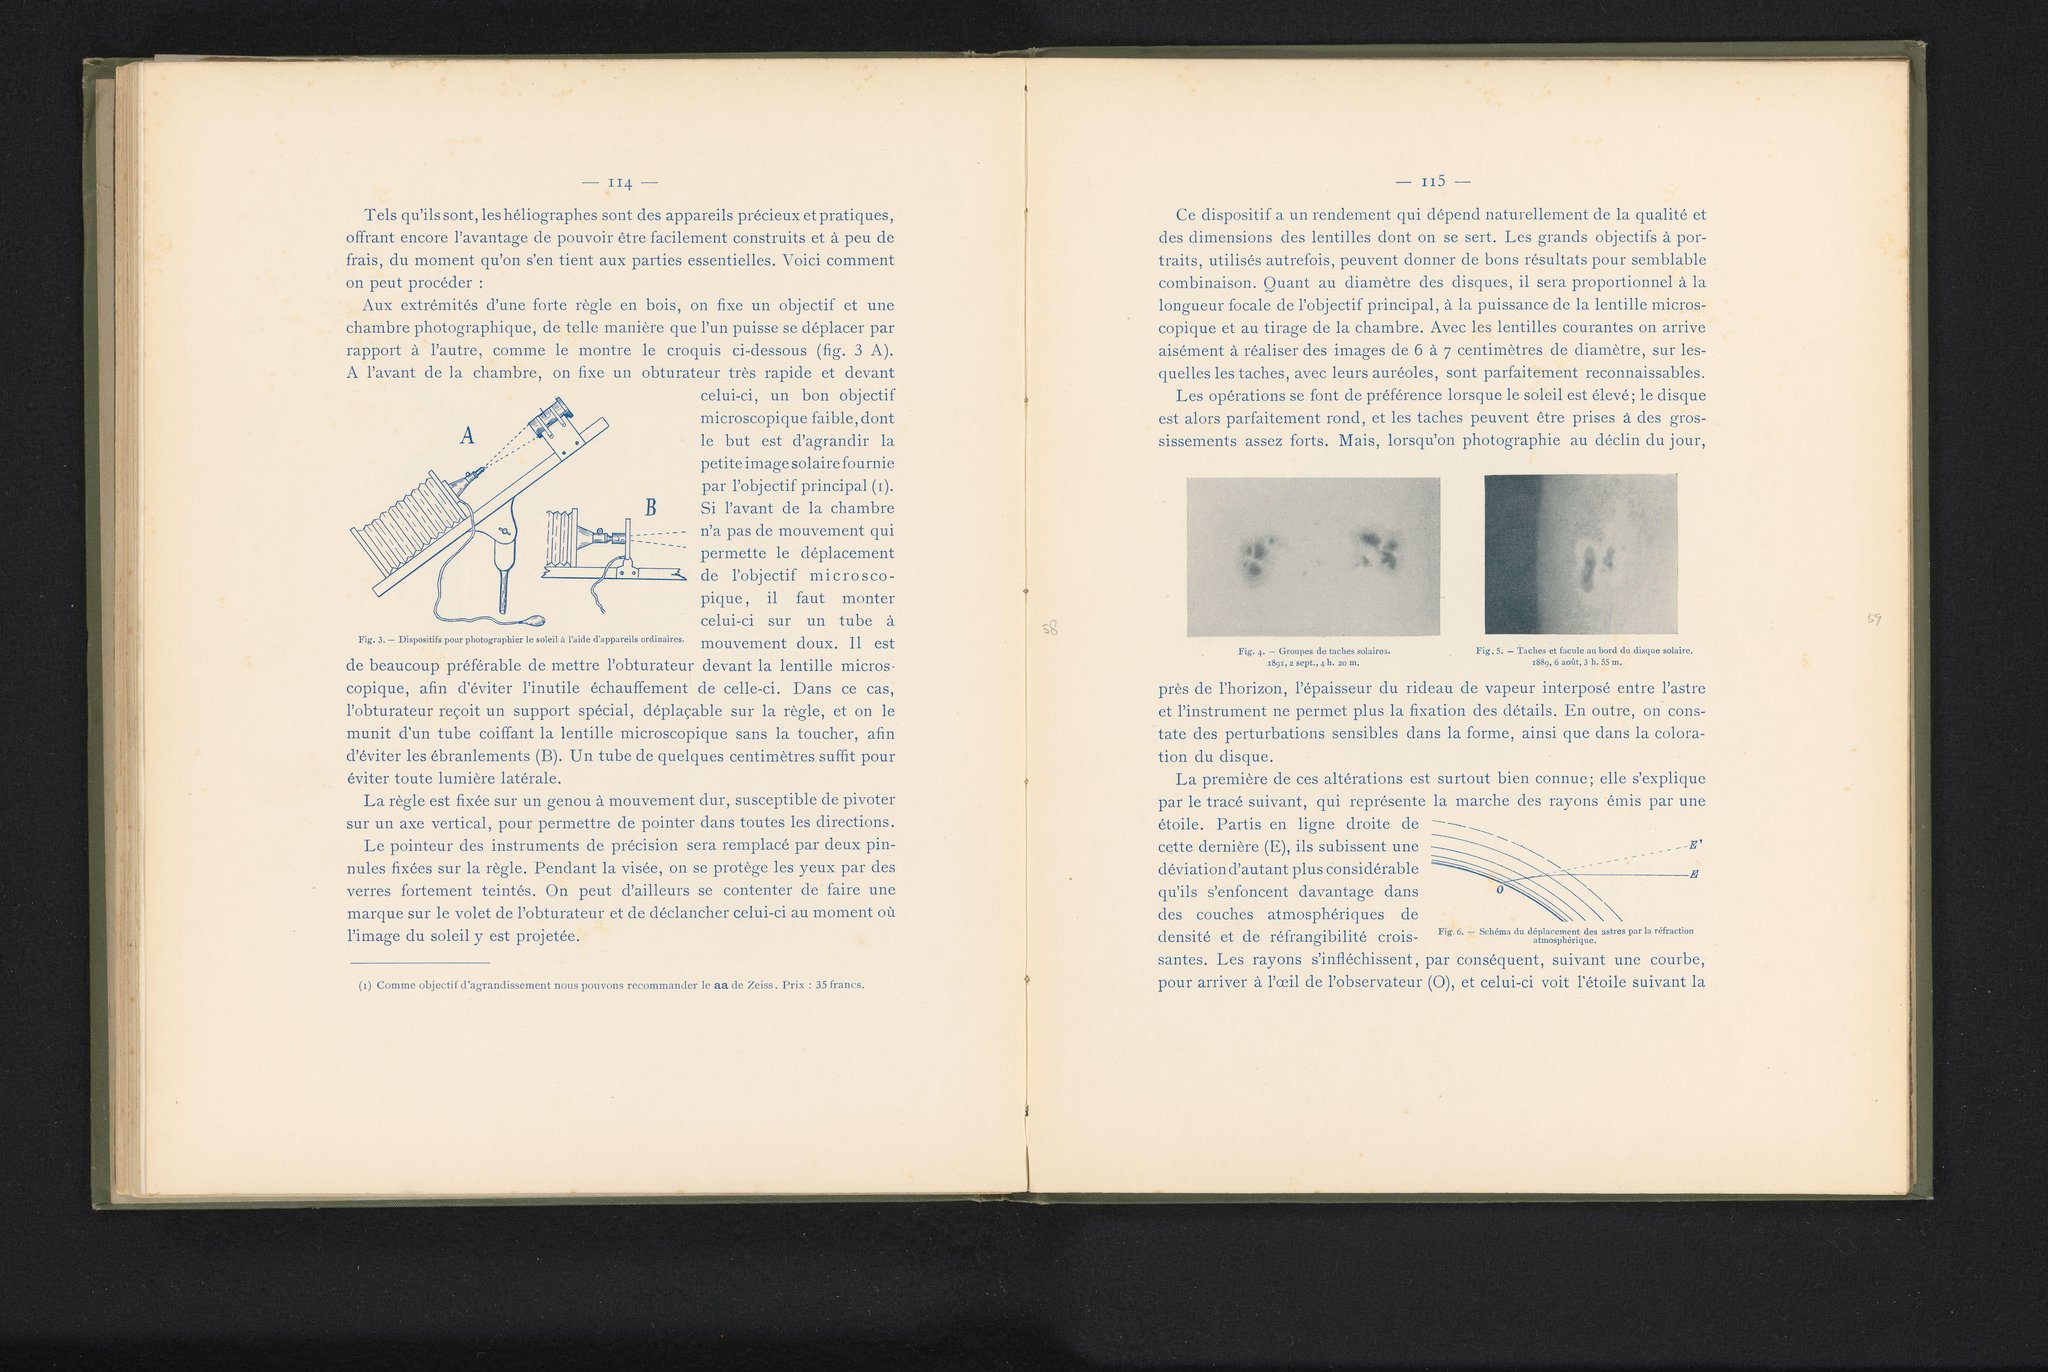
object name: page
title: Zonnevlekken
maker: Anonymous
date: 1893-1898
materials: paper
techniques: autotype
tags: sun-spots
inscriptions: inscription: ‘Fig. 5. - Taches et facule au bord du disque solaire. 1889, 6 août, 3 h. 55 m.’